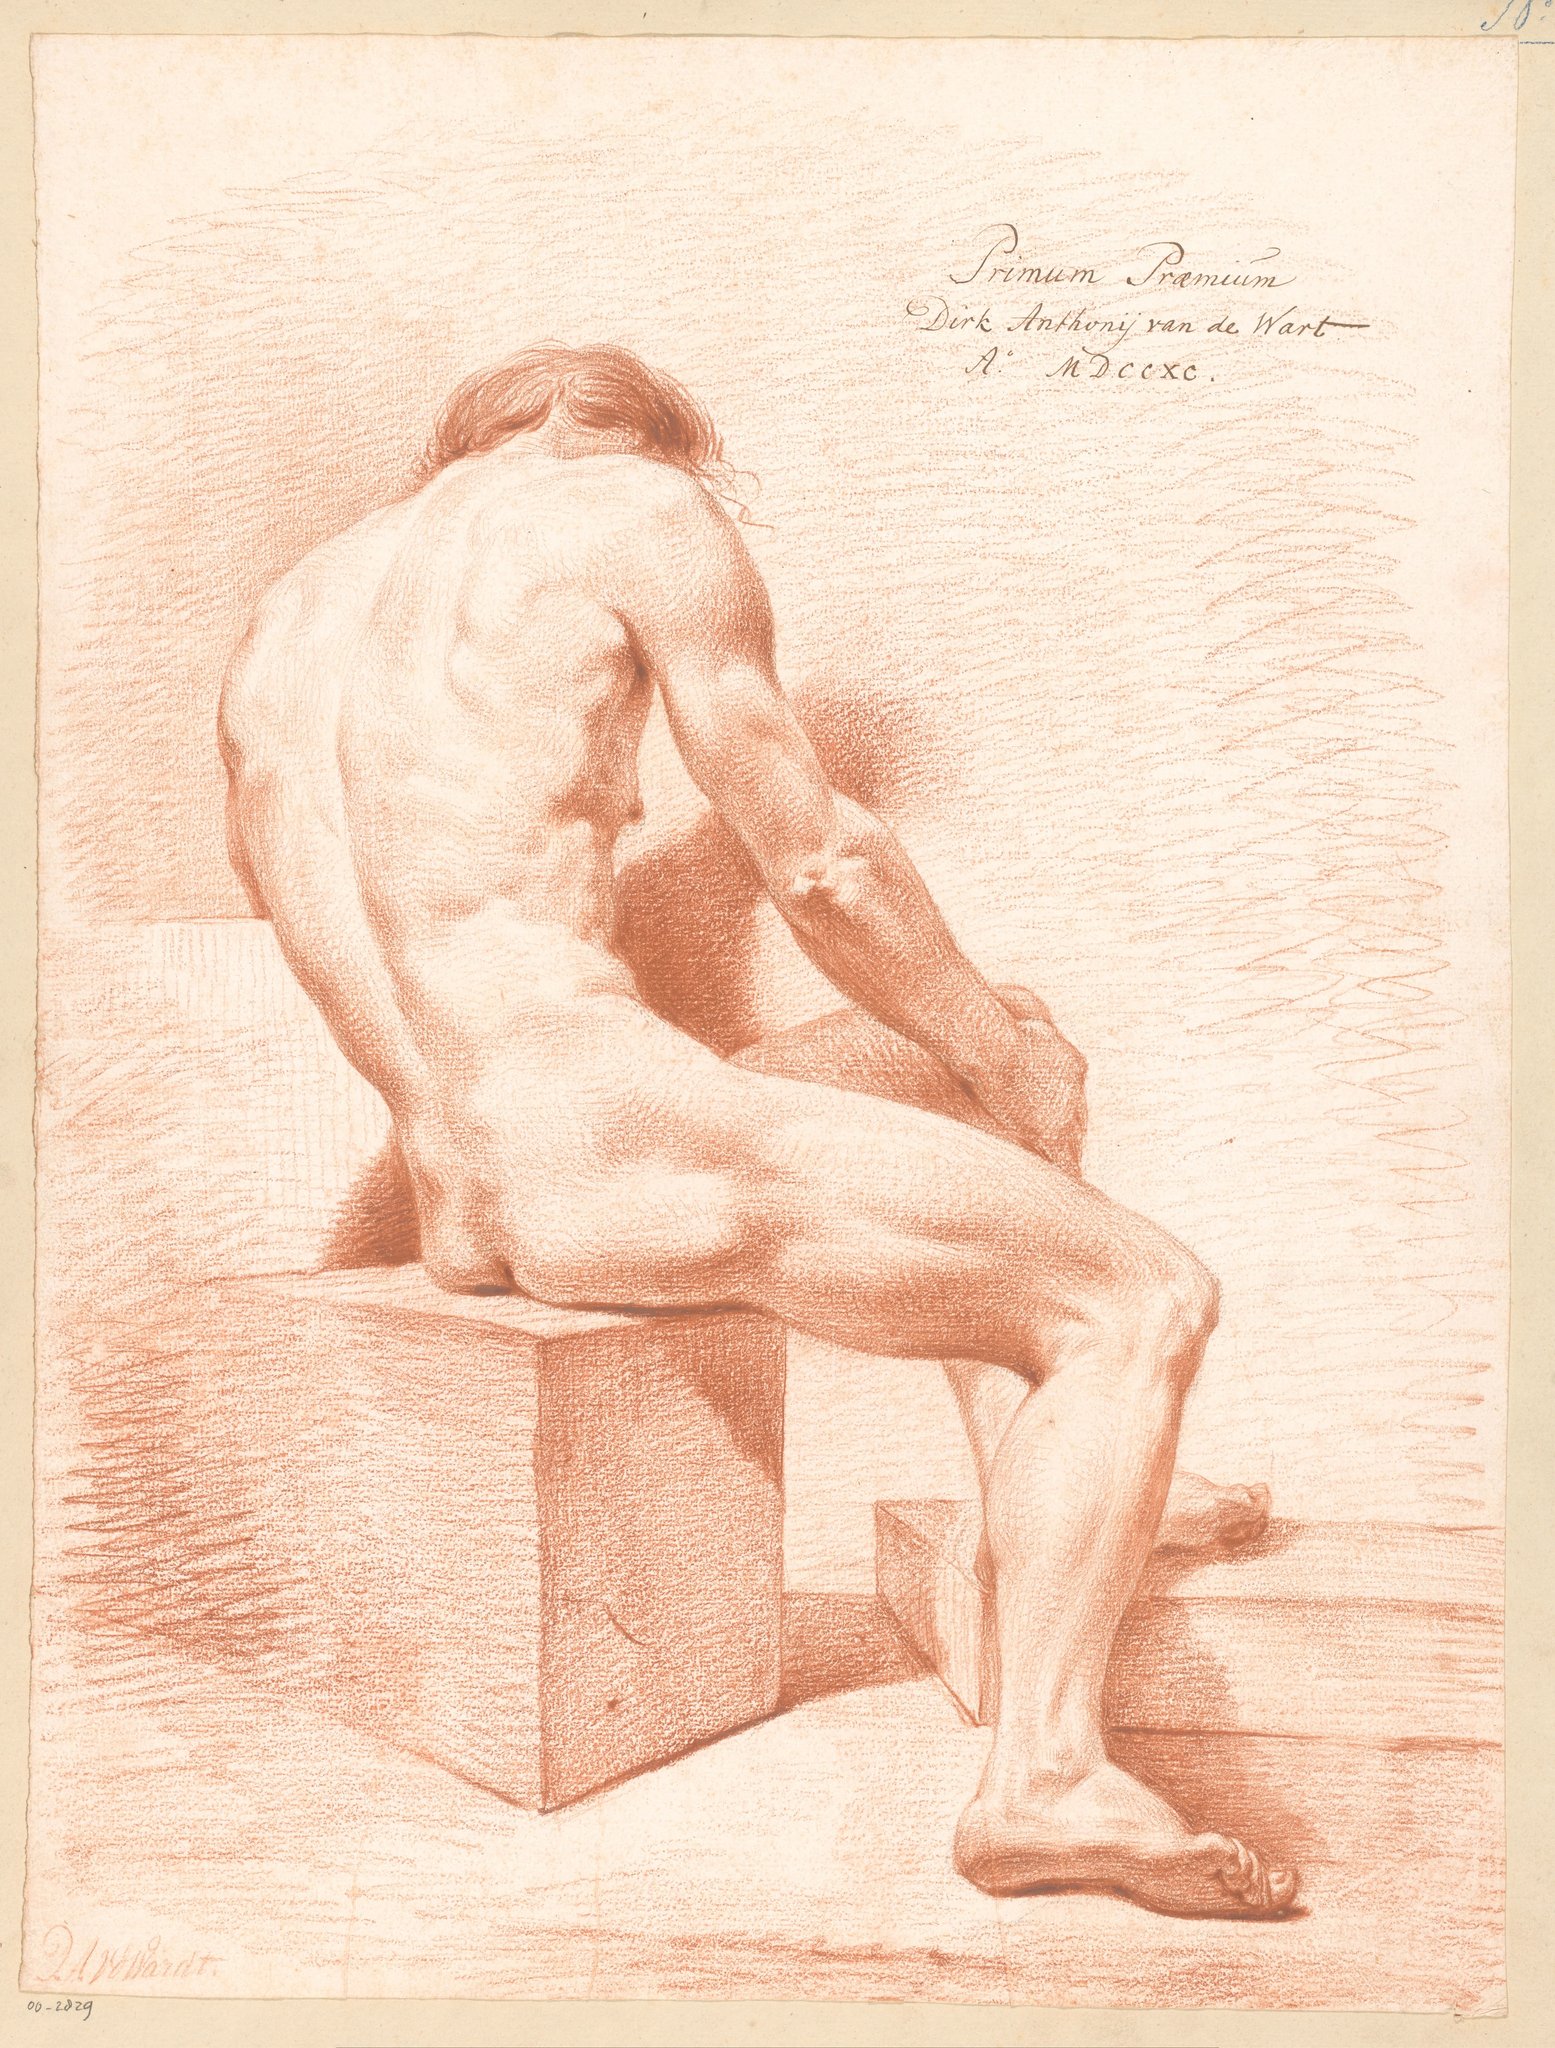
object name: drawing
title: Zittend mannelijk naakt, op de rug gezien (1e prijs 1790)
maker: derk anthony van de wart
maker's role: draughtsman, painter, print maker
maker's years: 1767-1824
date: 1790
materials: chalk, charcoal, paper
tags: sitting figure (+ nude human being)